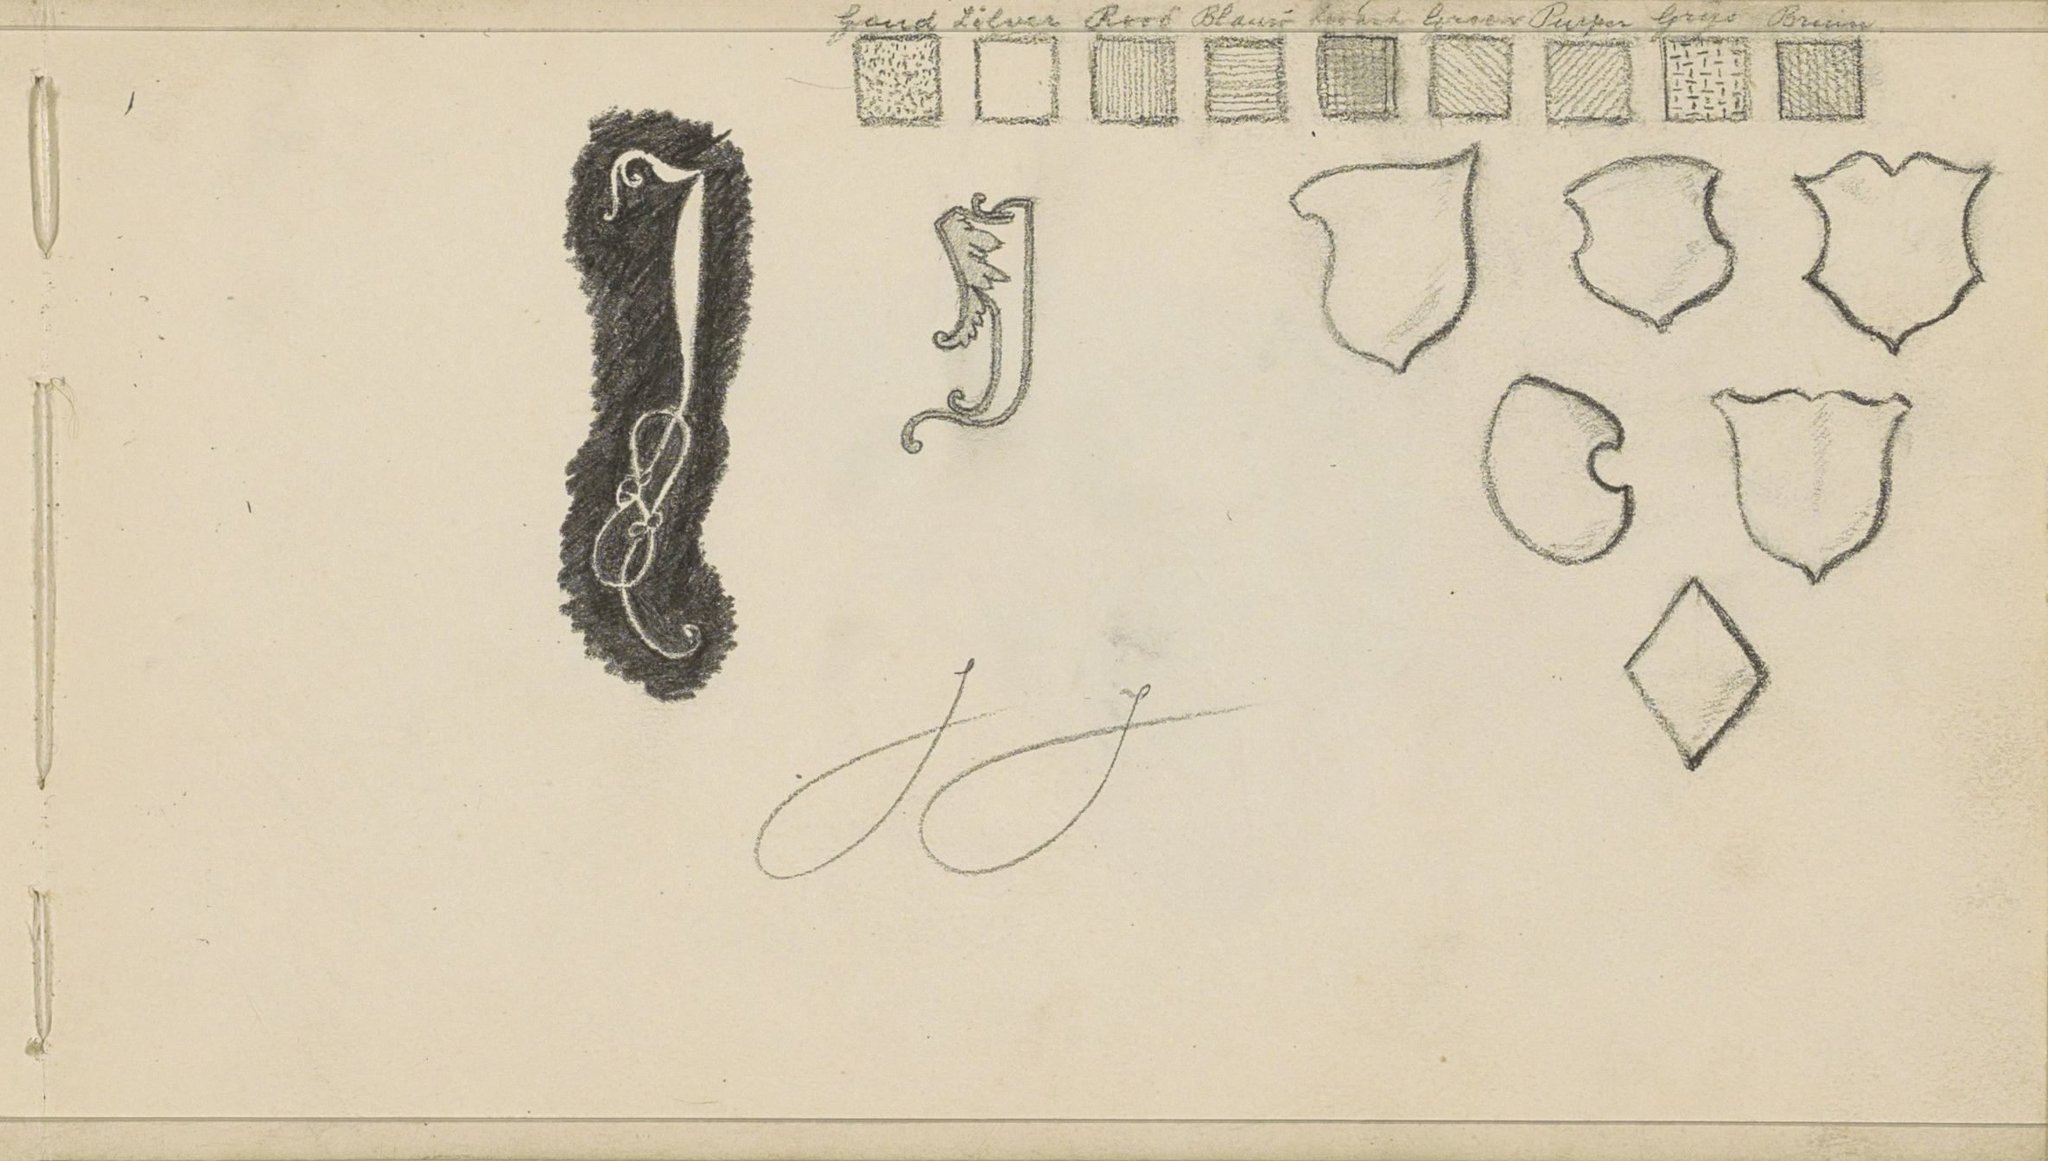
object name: sketchbook leaf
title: Gestileerde hoofdletters J, kleurstudies en fantasievormen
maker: julie de graag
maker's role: draughtsman, print maker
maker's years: 1877-1924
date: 1892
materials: paper, pencil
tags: fancy letters, colours, pigments, and paints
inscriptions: annotation: ‘Goud Zilver Rood Blauw Kobalt Groen Purper Grijs Bruin./ J J/ JJ’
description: Blad 4 recto uit een schetsboek met 22 bladen.